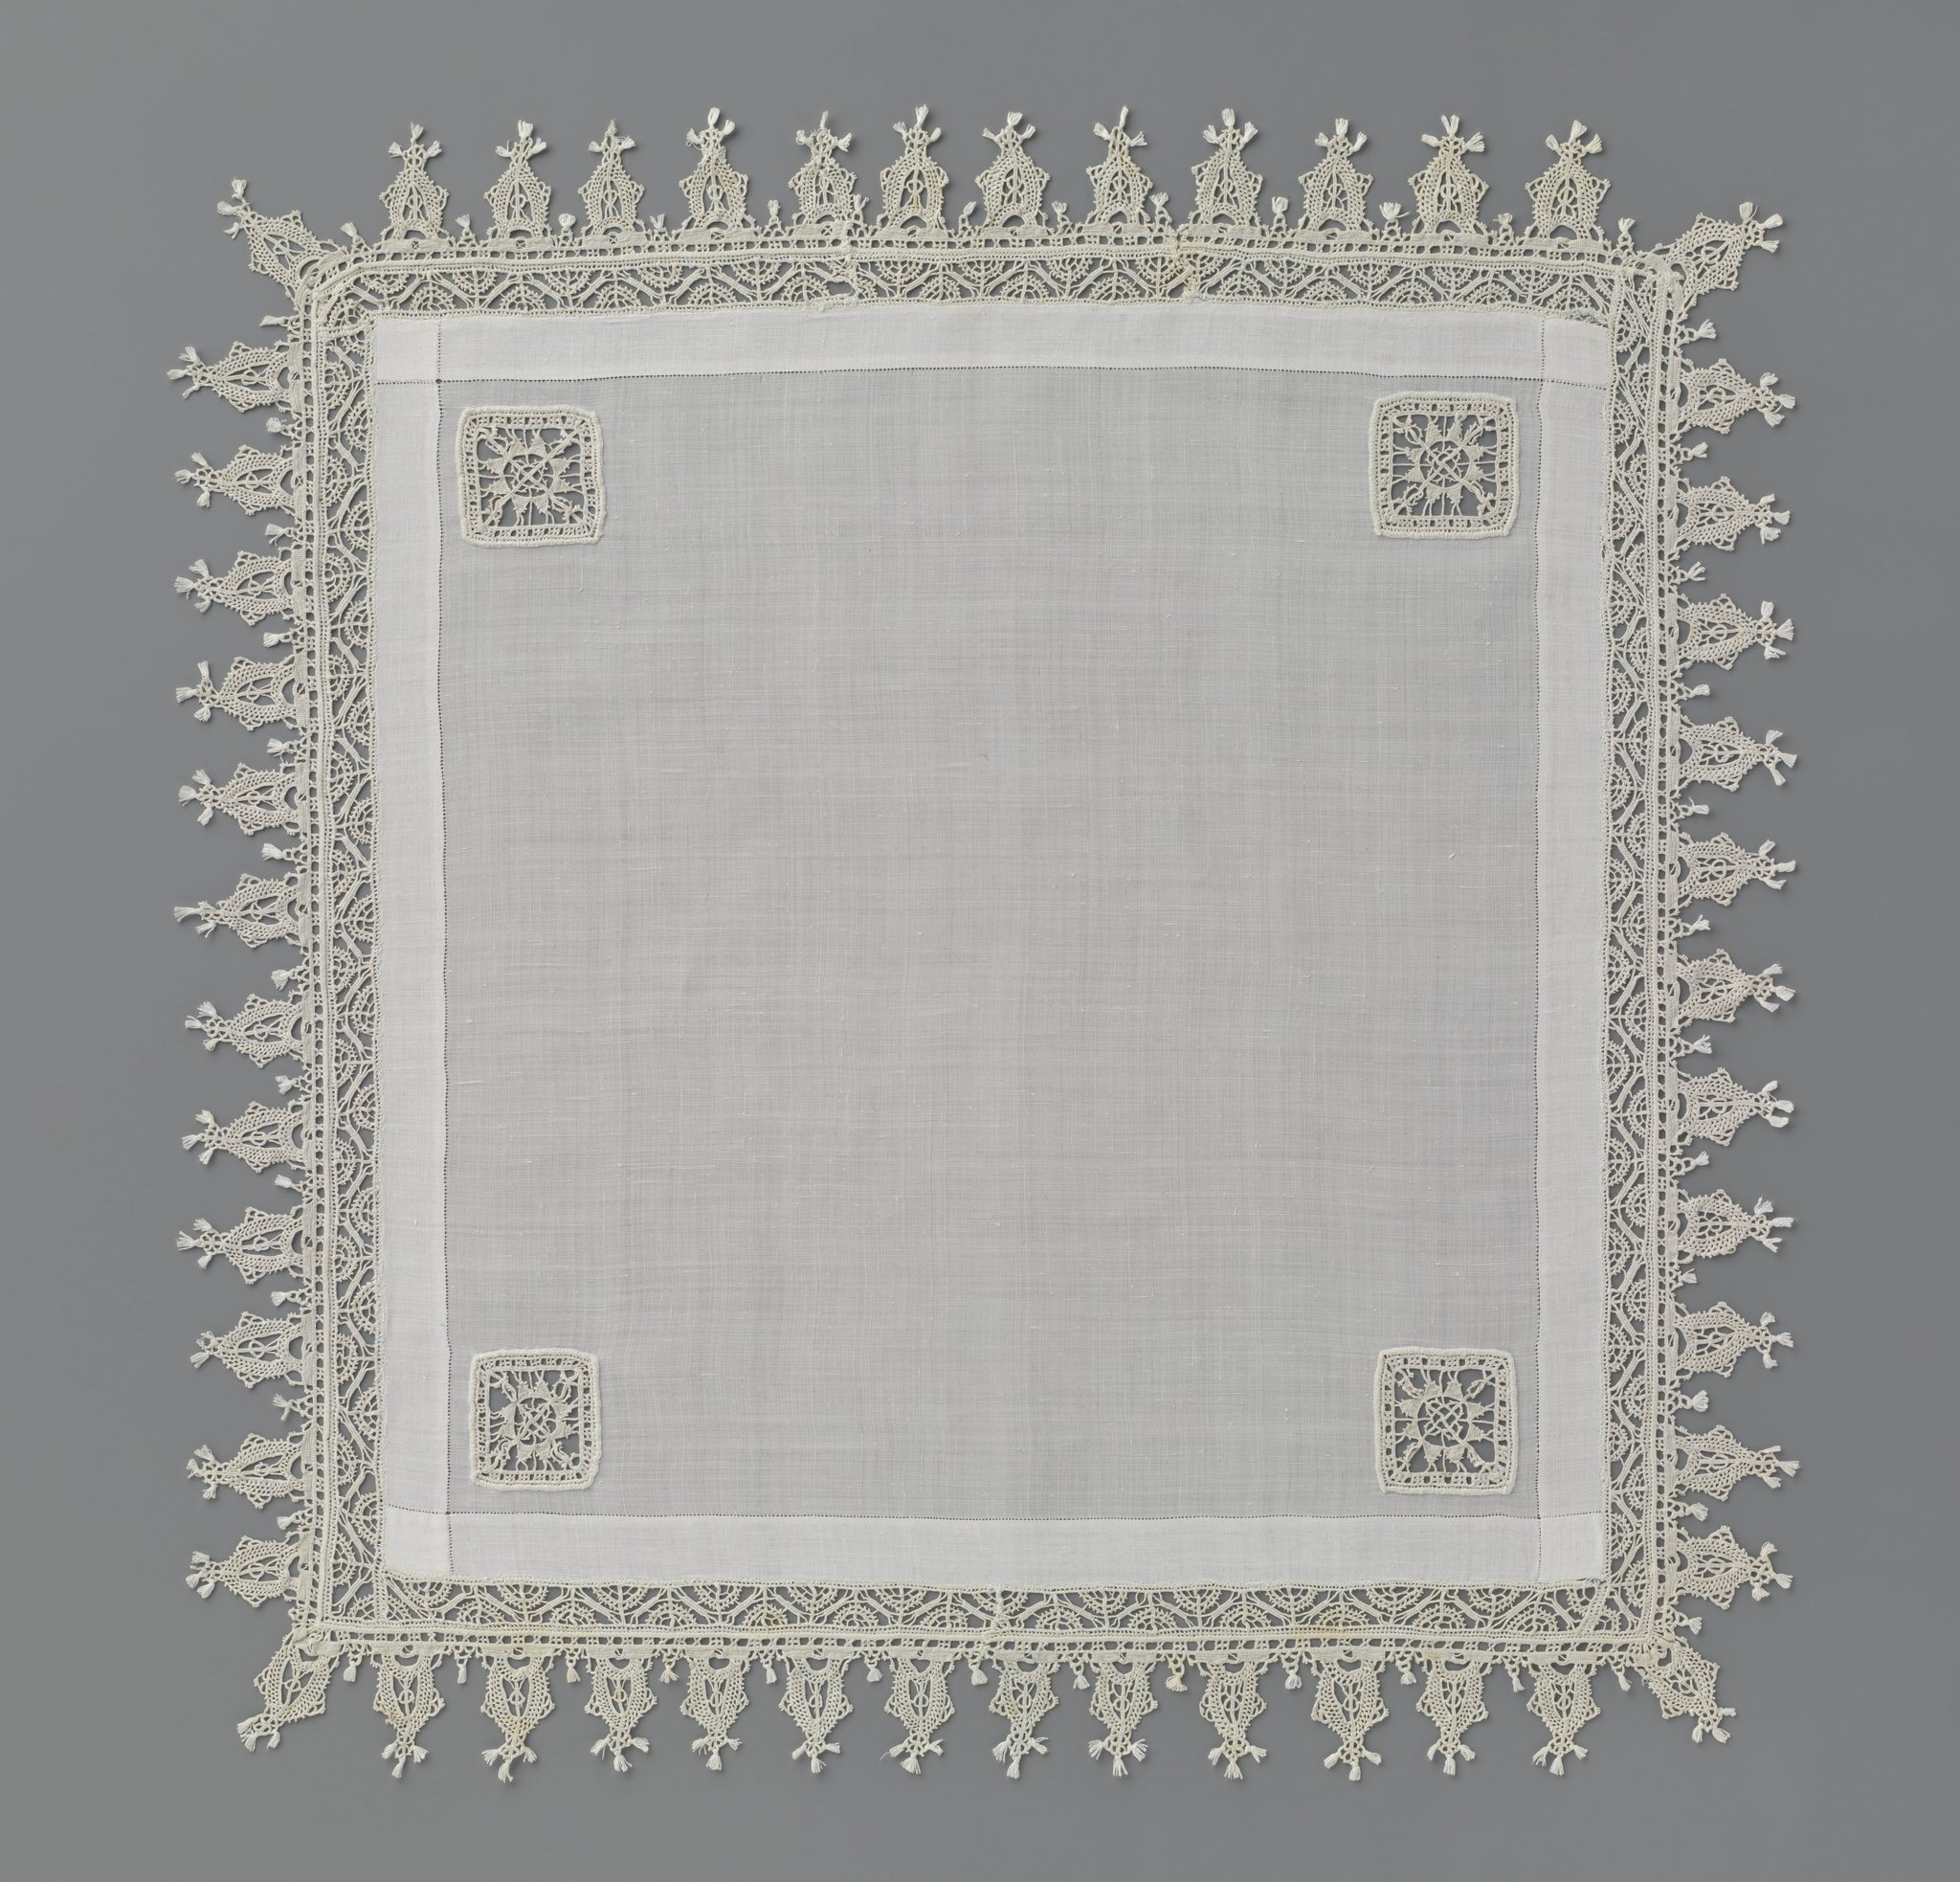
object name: clothing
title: Zakdoek van linnen batist, voorzien van vier inzetten en een tussenzetsel van naaldkant (point coupé), rondom afgezet met een dito schulprand en miniatuurkwastjes (akers)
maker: Anonymous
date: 1500-1599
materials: linen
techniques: knotting, weave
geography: italy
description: Zakdoek van linnen batist, voorzien van vier inzetten en een tussenzetsel van fijne naaldkant (point coupé), rondom afgezet met een dito schulprand en miniatuurkwastjes (akers).